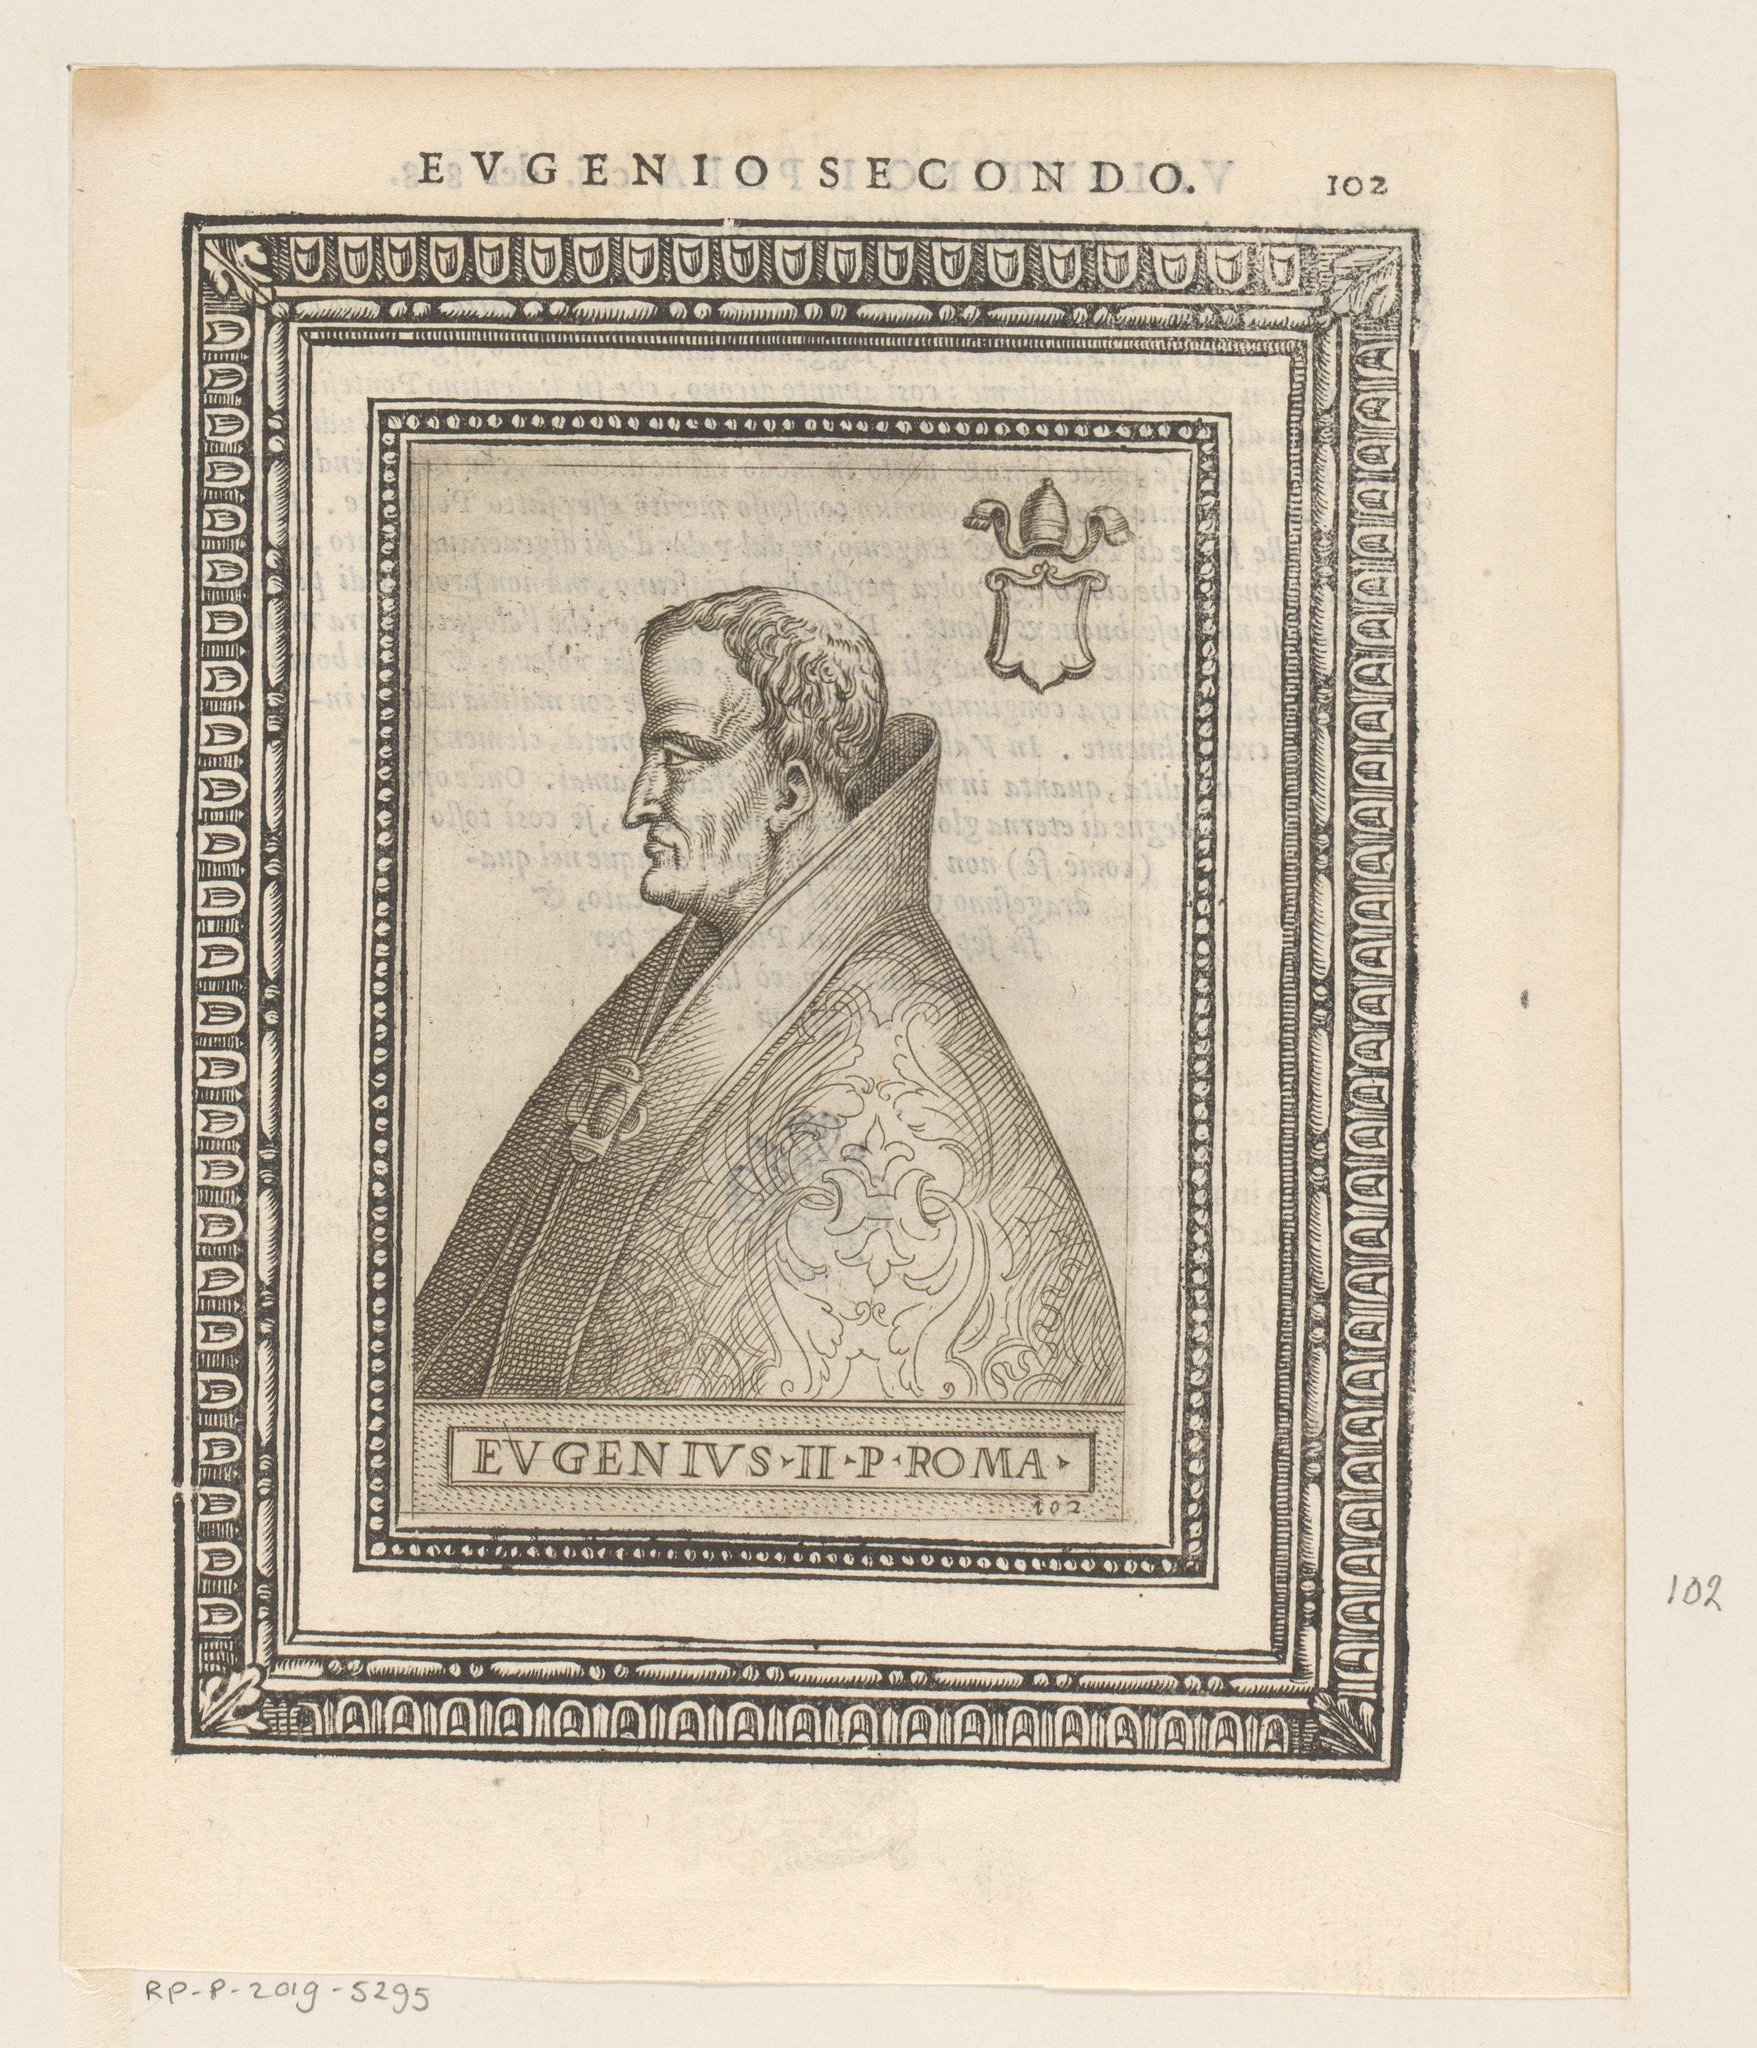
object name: print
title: Portret van paus Eugenius II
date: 1587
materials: paper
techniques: engraving, letterpress printing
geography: rome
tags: historical persons, pope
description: Prent uit: Ciccarelli, Antonio. Le vite de Pontefici di Antonio Ciccarelli (...). Rome: Domenico Basa, 1587. Prent voor het eerst verschenen in: Cavalieri, Giovanni Battista de'. Pontificum romanorum effigies (...). Rome: Domenico Basa en Francesco Zanetti, 1580. Prent ook gebruikt in latere publicaties.